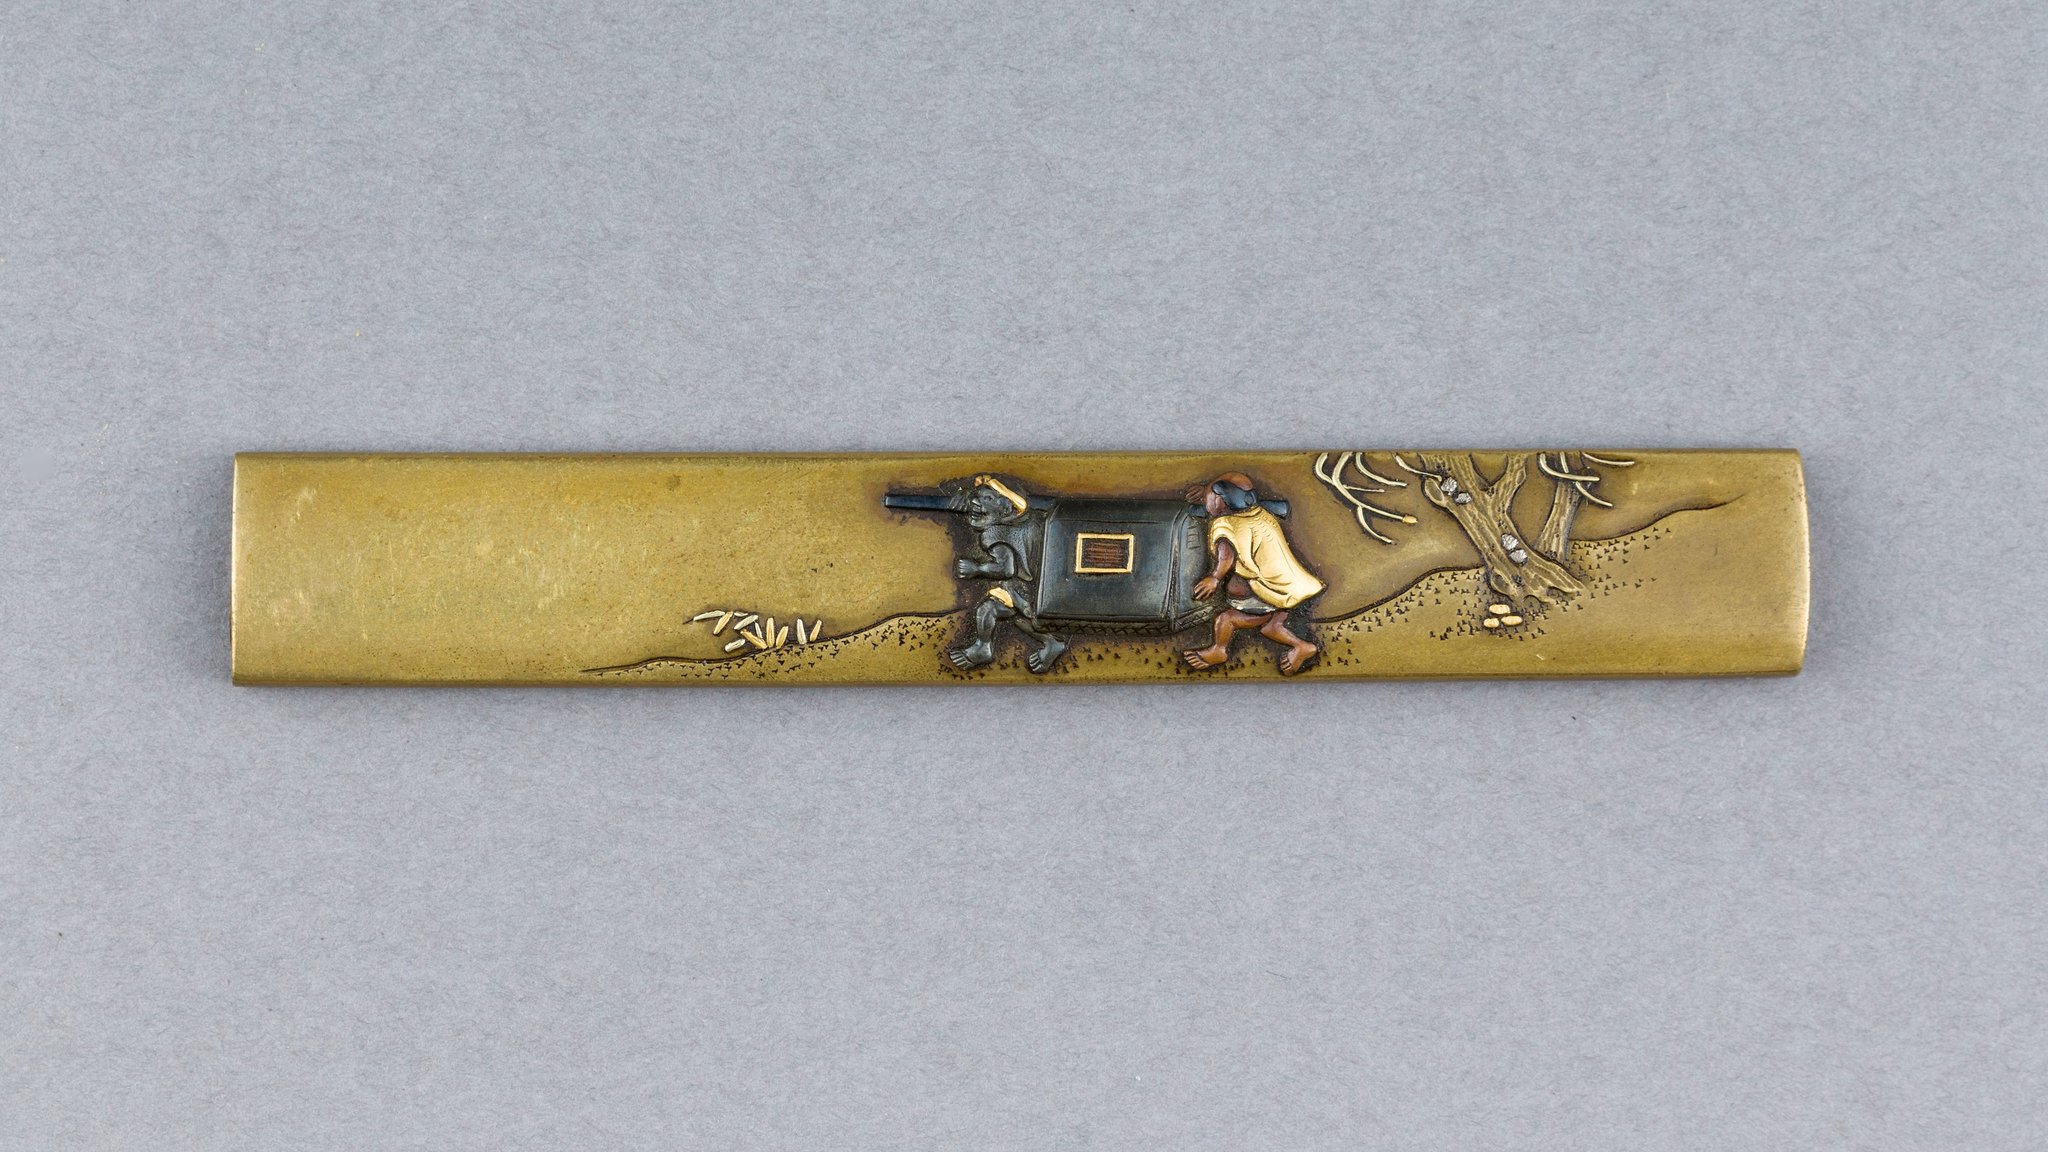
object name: knife handle kozuka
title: Knife Handle (Kozuka)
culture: japanese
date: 1615-1868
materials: copper, copper alloy, gold alloy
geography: japan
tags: men